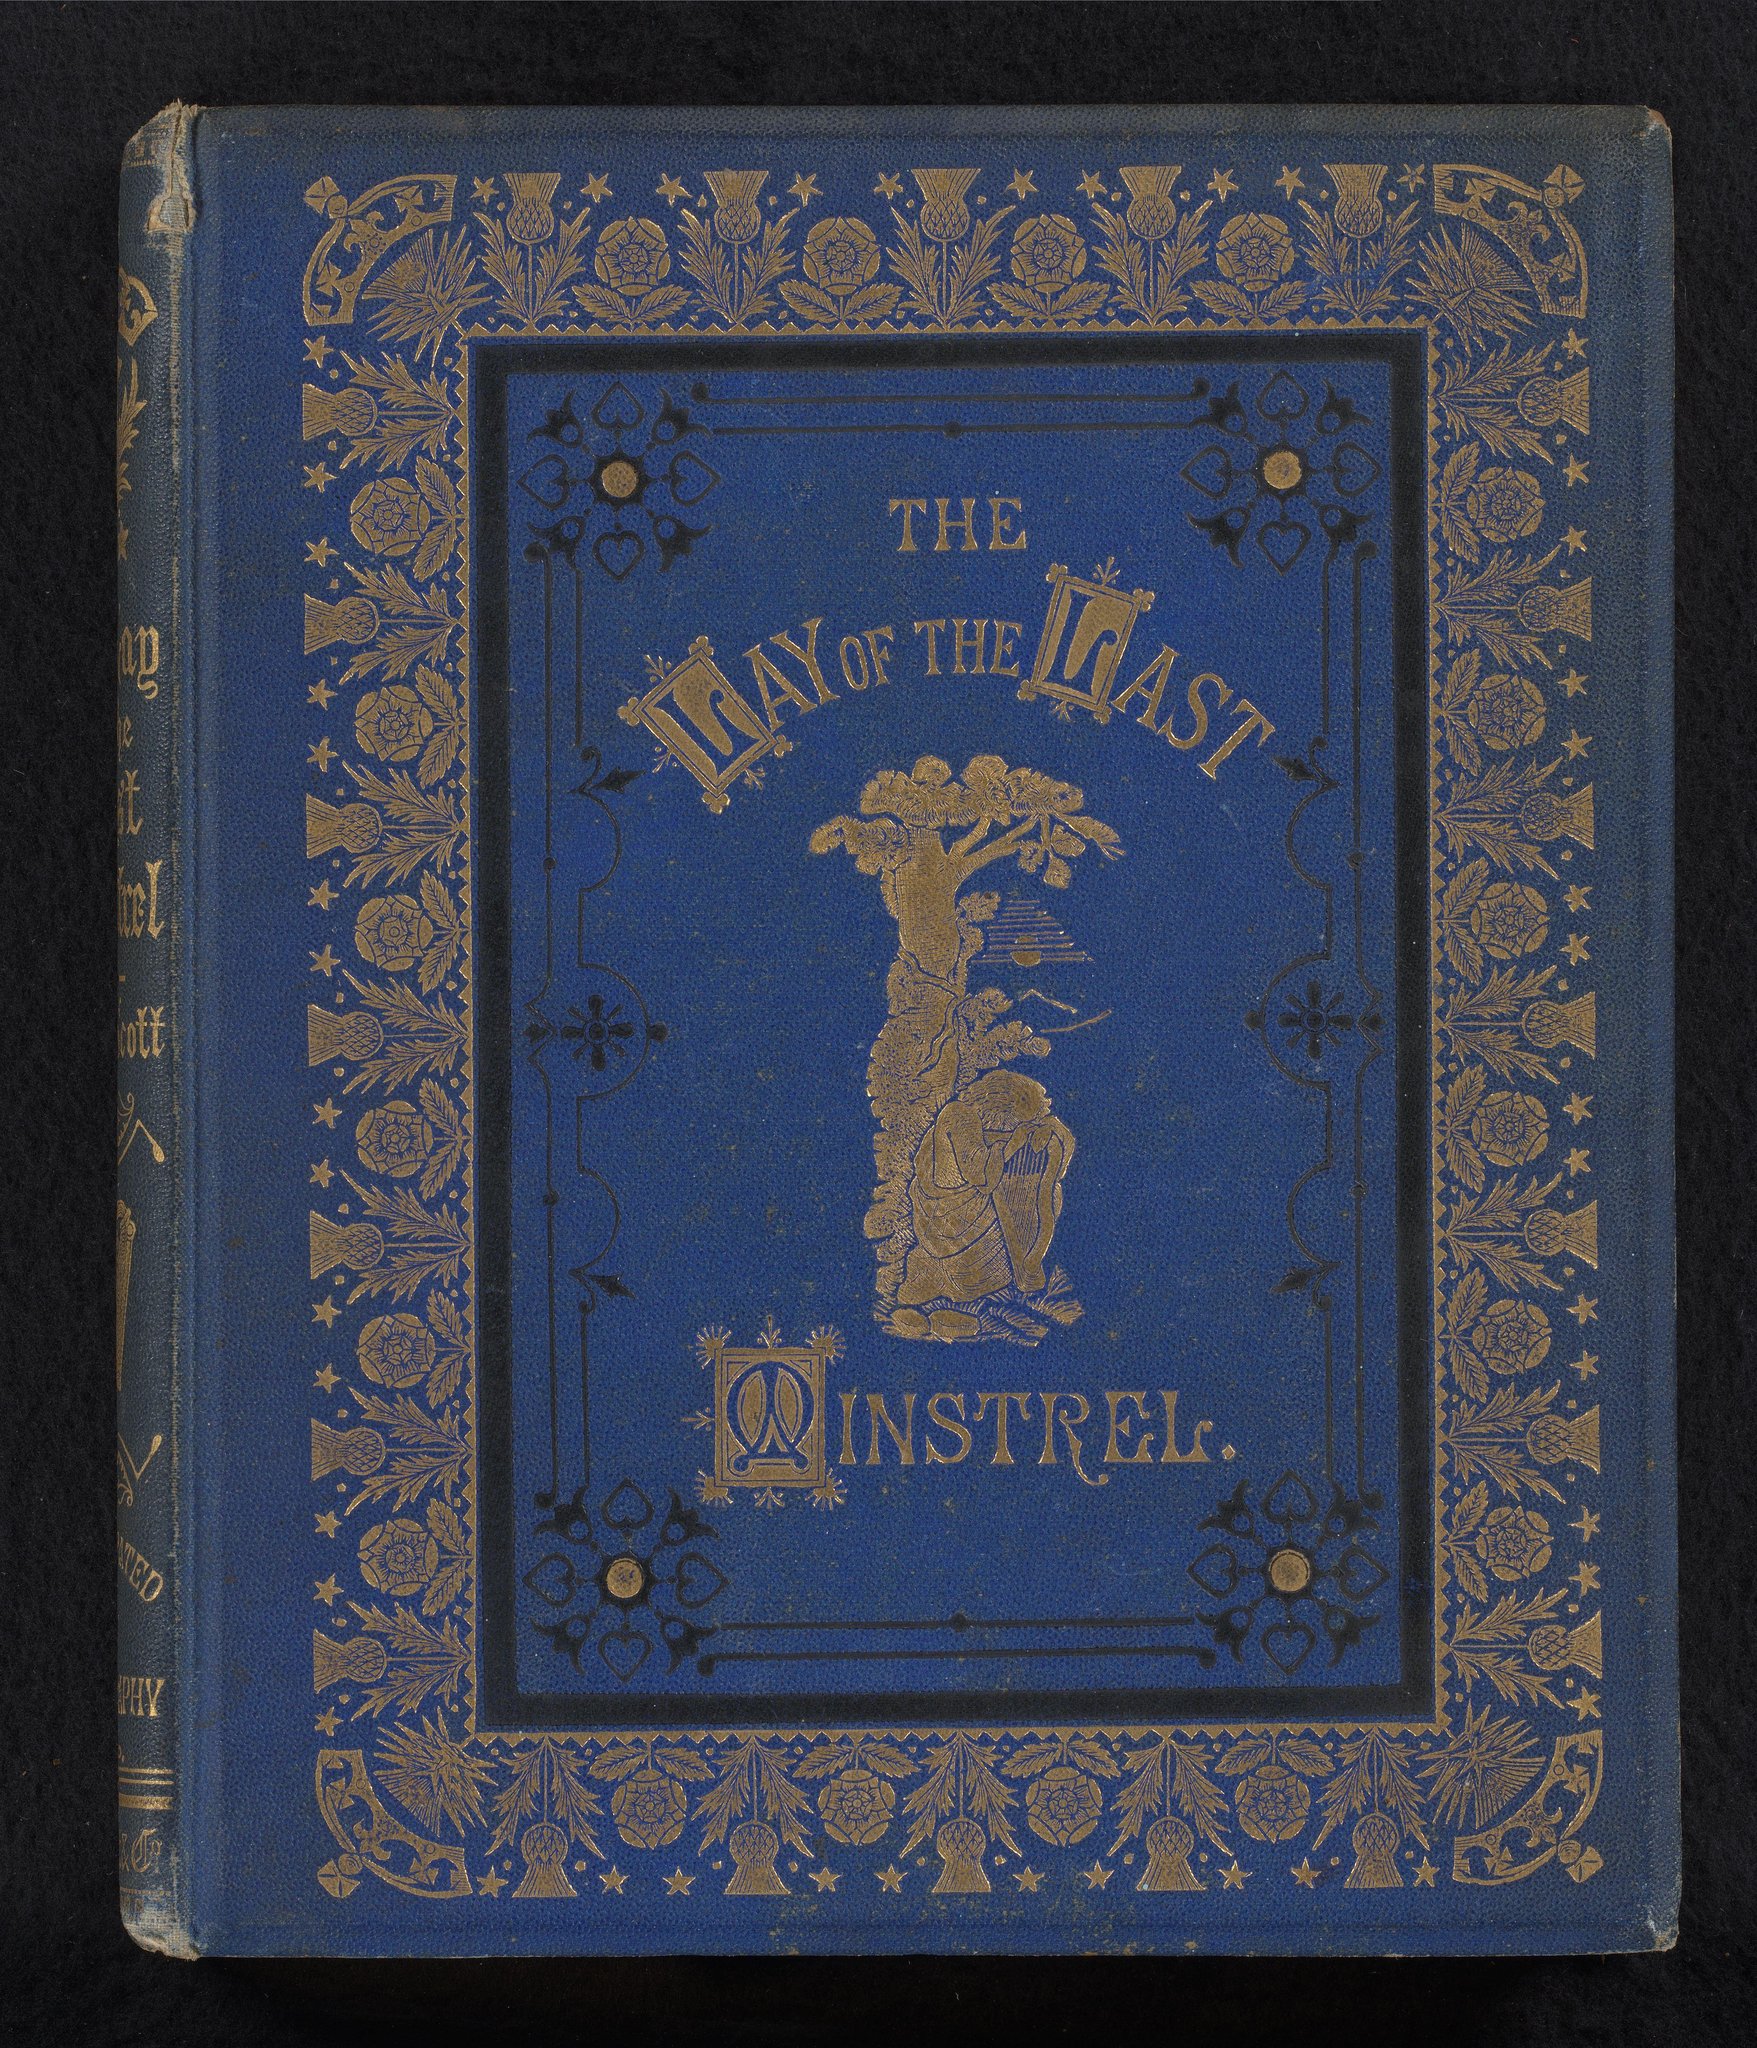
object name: book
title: The lay of the last minstrel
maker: walter scott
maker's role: dichter, schrijver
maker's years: 1771-1832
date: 1872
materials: cardboard, paper, linen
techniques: albumen print, letterpress printing, printing block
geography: london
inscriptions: inscription: ‘10/6 [?]’, inscription: ‘£20/ E2’, inscription: ‘Pamela Disbet’